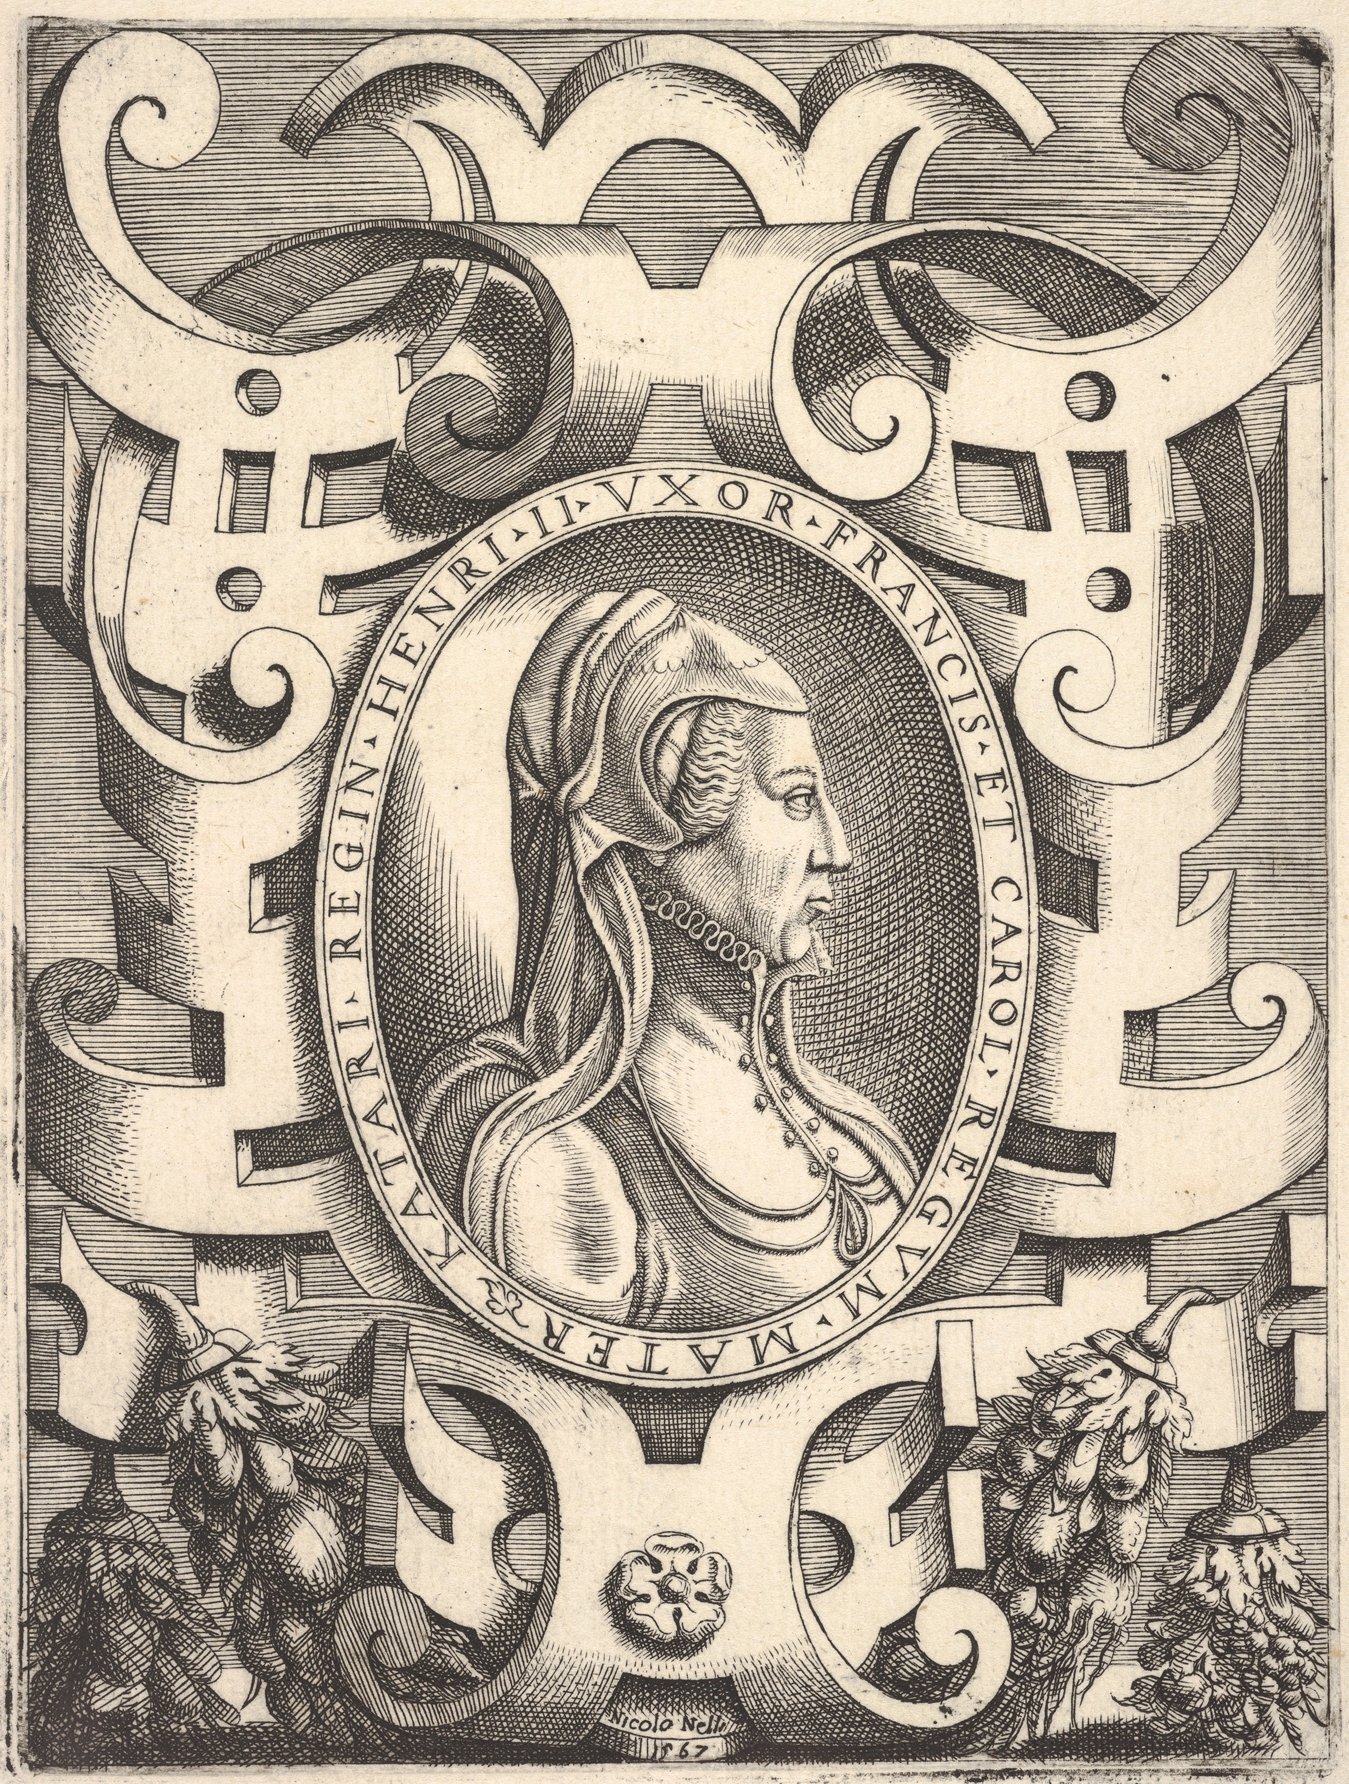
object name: print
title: Bust profile portrait of Catherine de' Medici in an ornamented frame, from "Portraits of some princes and illustrious people" (Ritratti di alcuni prencipi, et huomini illustri; also titled Imagines quorundam principum et illustrium virorum)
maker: nicolò nelli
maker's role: artist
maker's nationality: italian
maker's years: 1552-1579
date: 1567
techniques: engraving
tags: queens,profiles